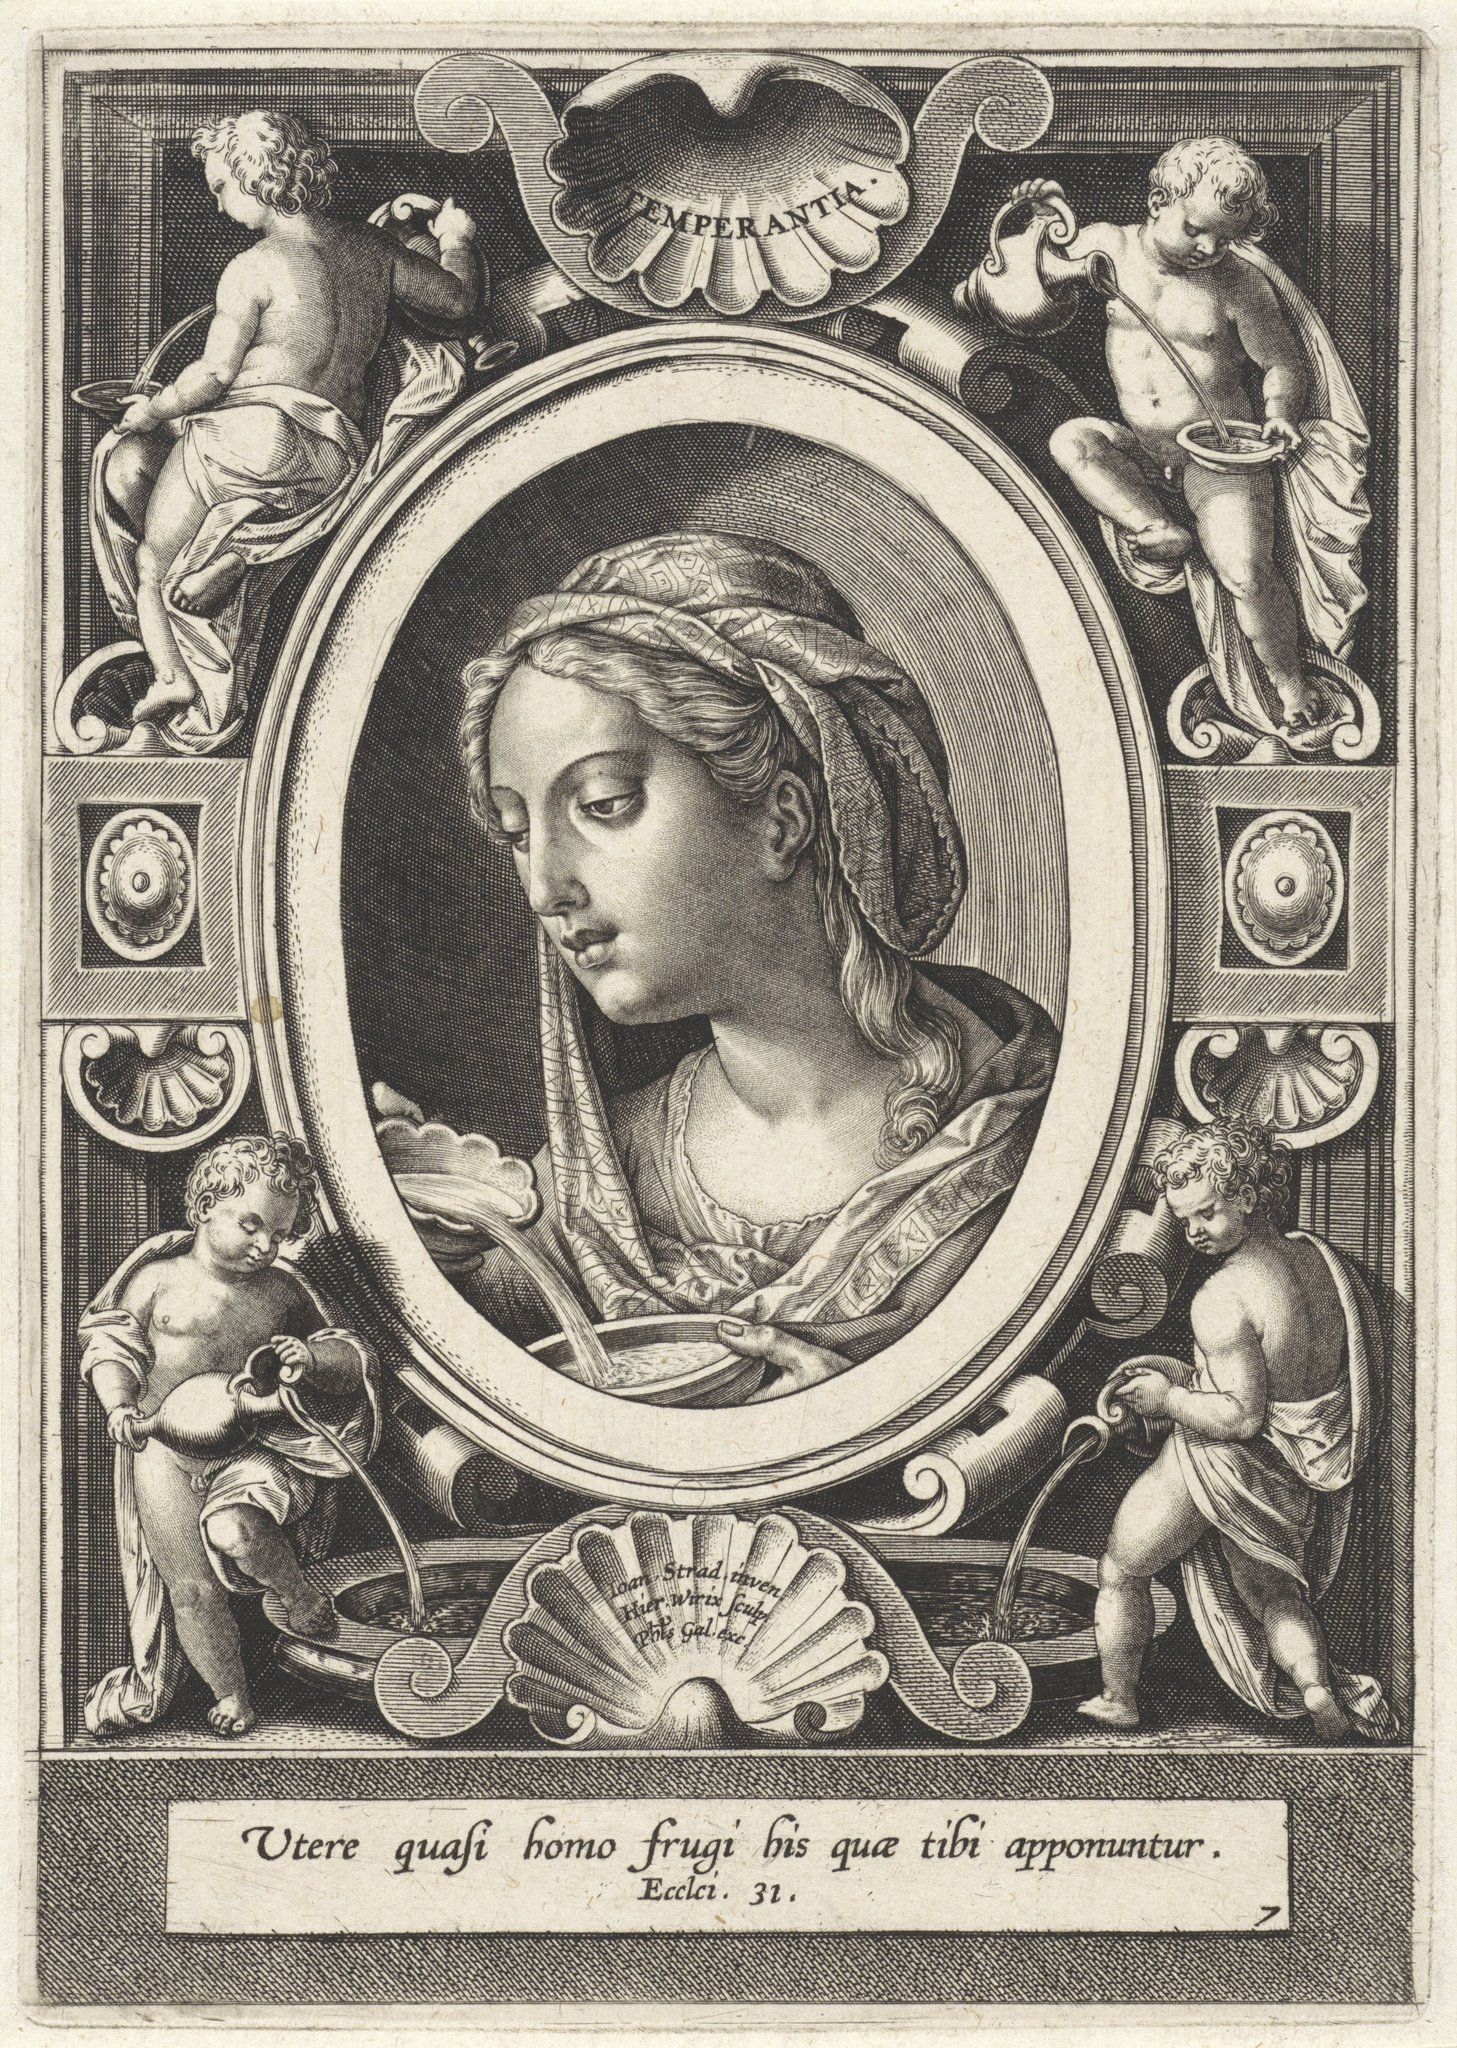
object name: print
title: Temperantia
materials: paper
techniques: engraving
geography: antwerp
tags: temperance, 'temperantia'; 'temperanza' (ripa) ~ one of the four cardinal virtues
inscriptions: collector's mark: Lugt 2233, collector's mark: Lugt 2542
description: Buste van de vrouwelijke personificatie van Matigheid. Ze giet met een schelp een vloeistof over in een schaal. De voorstelling is gevat in een cartouche, omringd door putti. In het kader in de marge een tweeregelig Bijbelcitaat uit Sir. 31 in het Latijn.